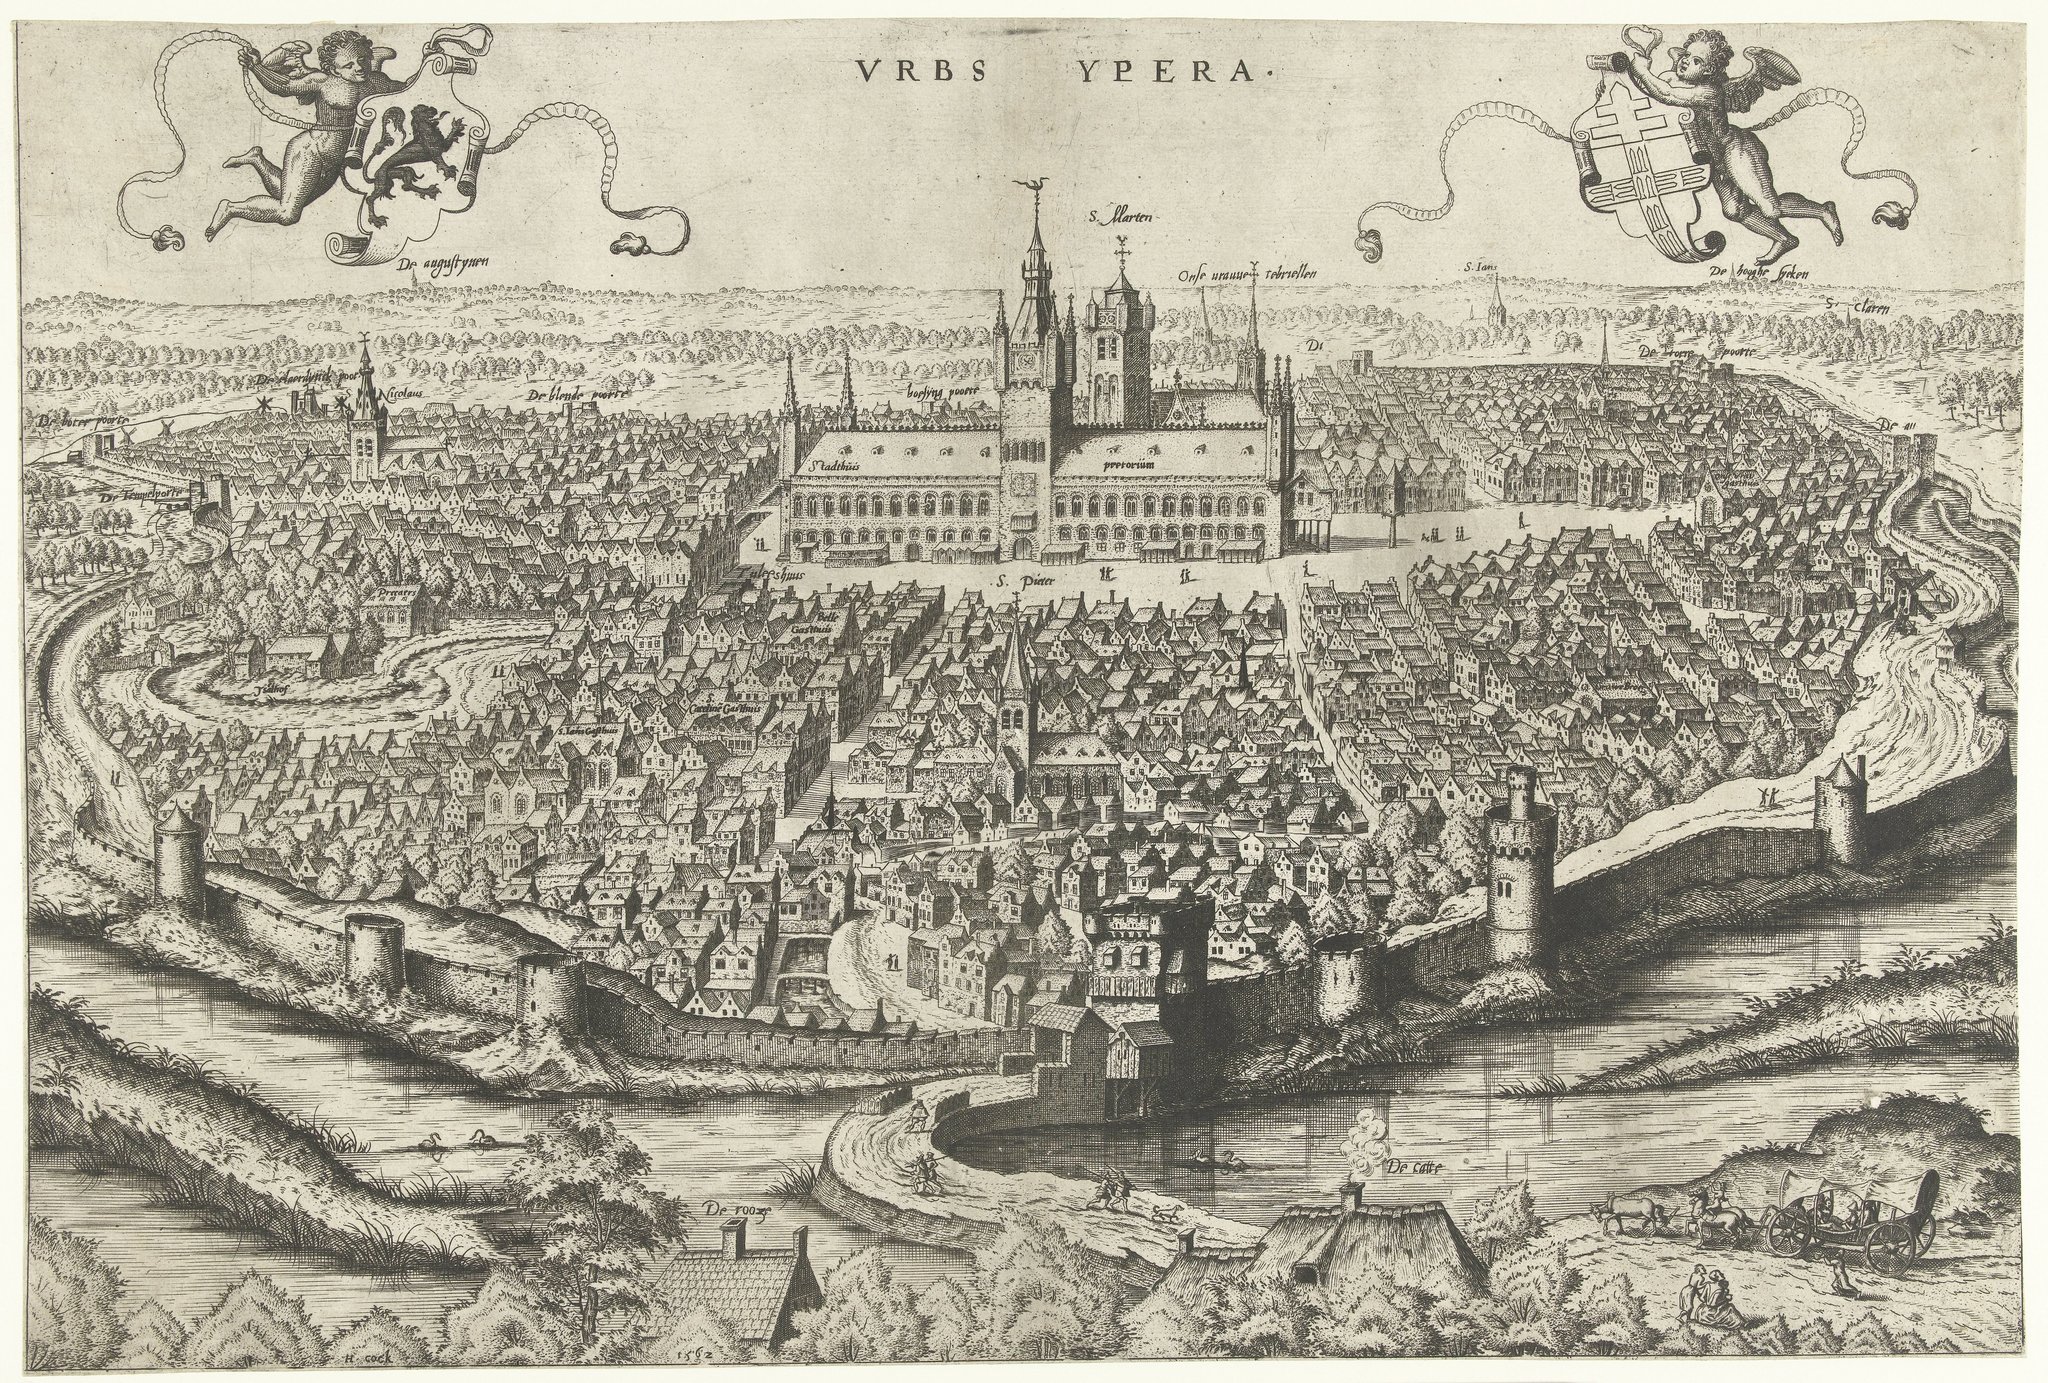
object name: print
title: Gezicht op Ieper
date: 1562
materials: paper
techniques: engraving, etching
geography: antwerp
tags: prospect of city, town panorama, silhouette of city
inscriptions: collector's mark: Lugt 2228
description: Vogelvluchtaanzicht van de stad Ieper met de lakenhal en de Sint Maartenskerk in het midden van de stad. Linksboven een engel met het wapen van Vlaanderen, rechts een engel met het stadswapen van Ieper.